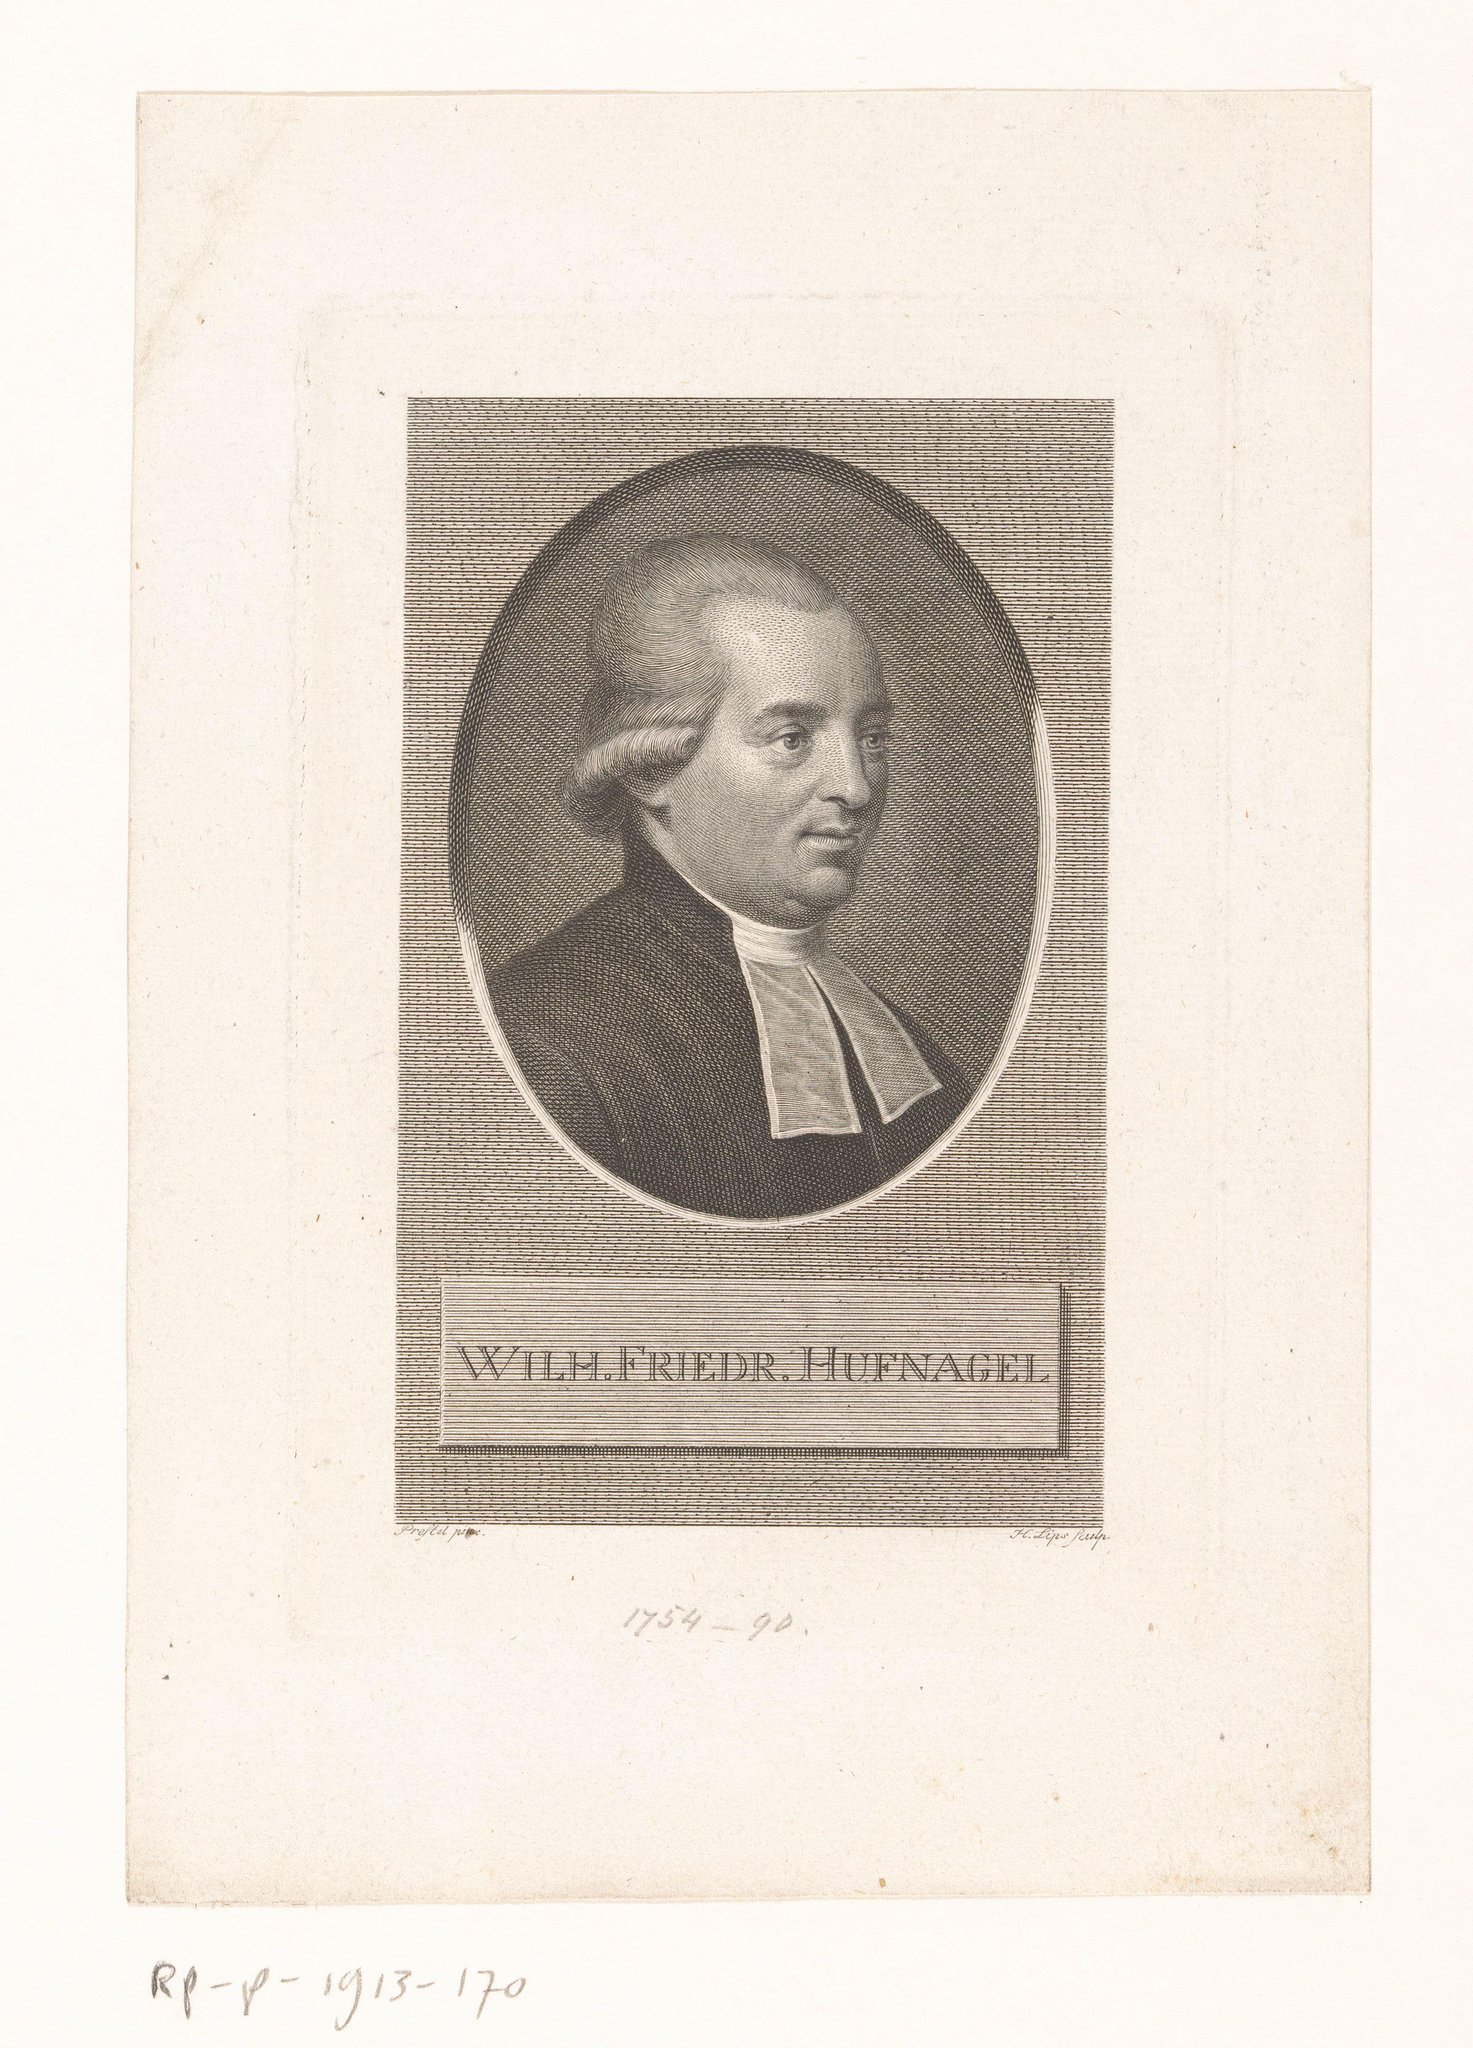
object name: print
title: Portret van Wilhelm Friedrich Hufnagel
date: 1768-1817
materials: paper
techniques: engraving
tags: historical persons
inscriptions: collector's mark: Lugt 2228, date